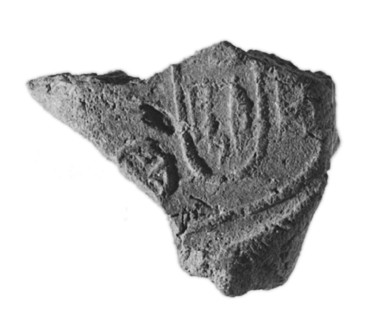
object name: sealing fragment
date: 2030-1640 BCE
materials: clay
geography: egypt